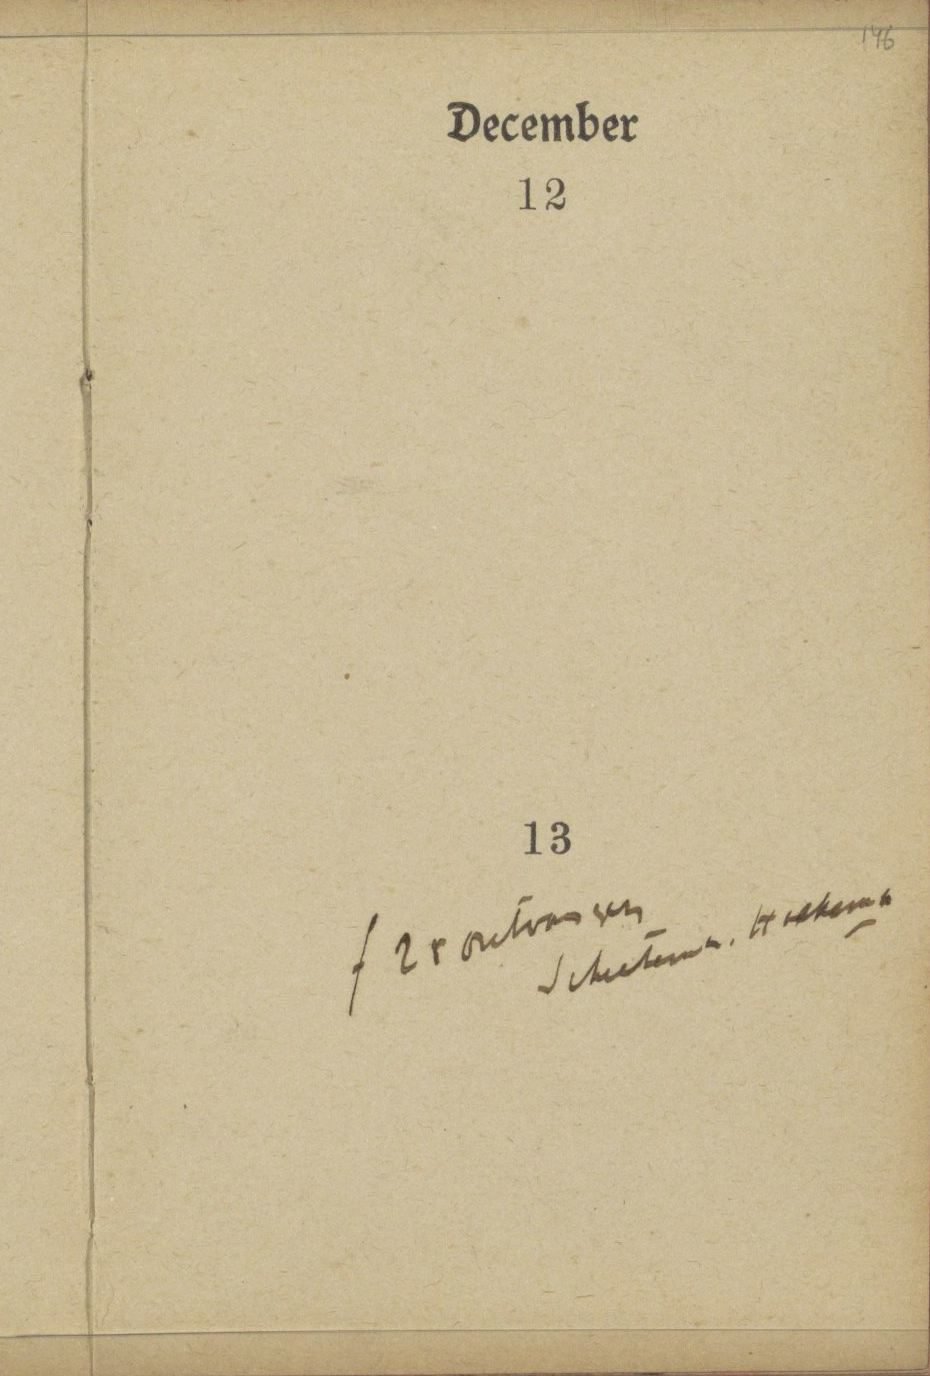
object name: sketchbook leaf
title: Annotaties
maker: george hendrik breitner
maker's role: draughtsman, painter, print maker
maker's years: 1857-1923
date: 1893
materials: ink, paper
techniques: writing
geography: amsterdam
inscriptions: annotation: ‘[...]’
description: Pagina 146 uit een als schetsboek gebruikte agenda met 80 bladen.